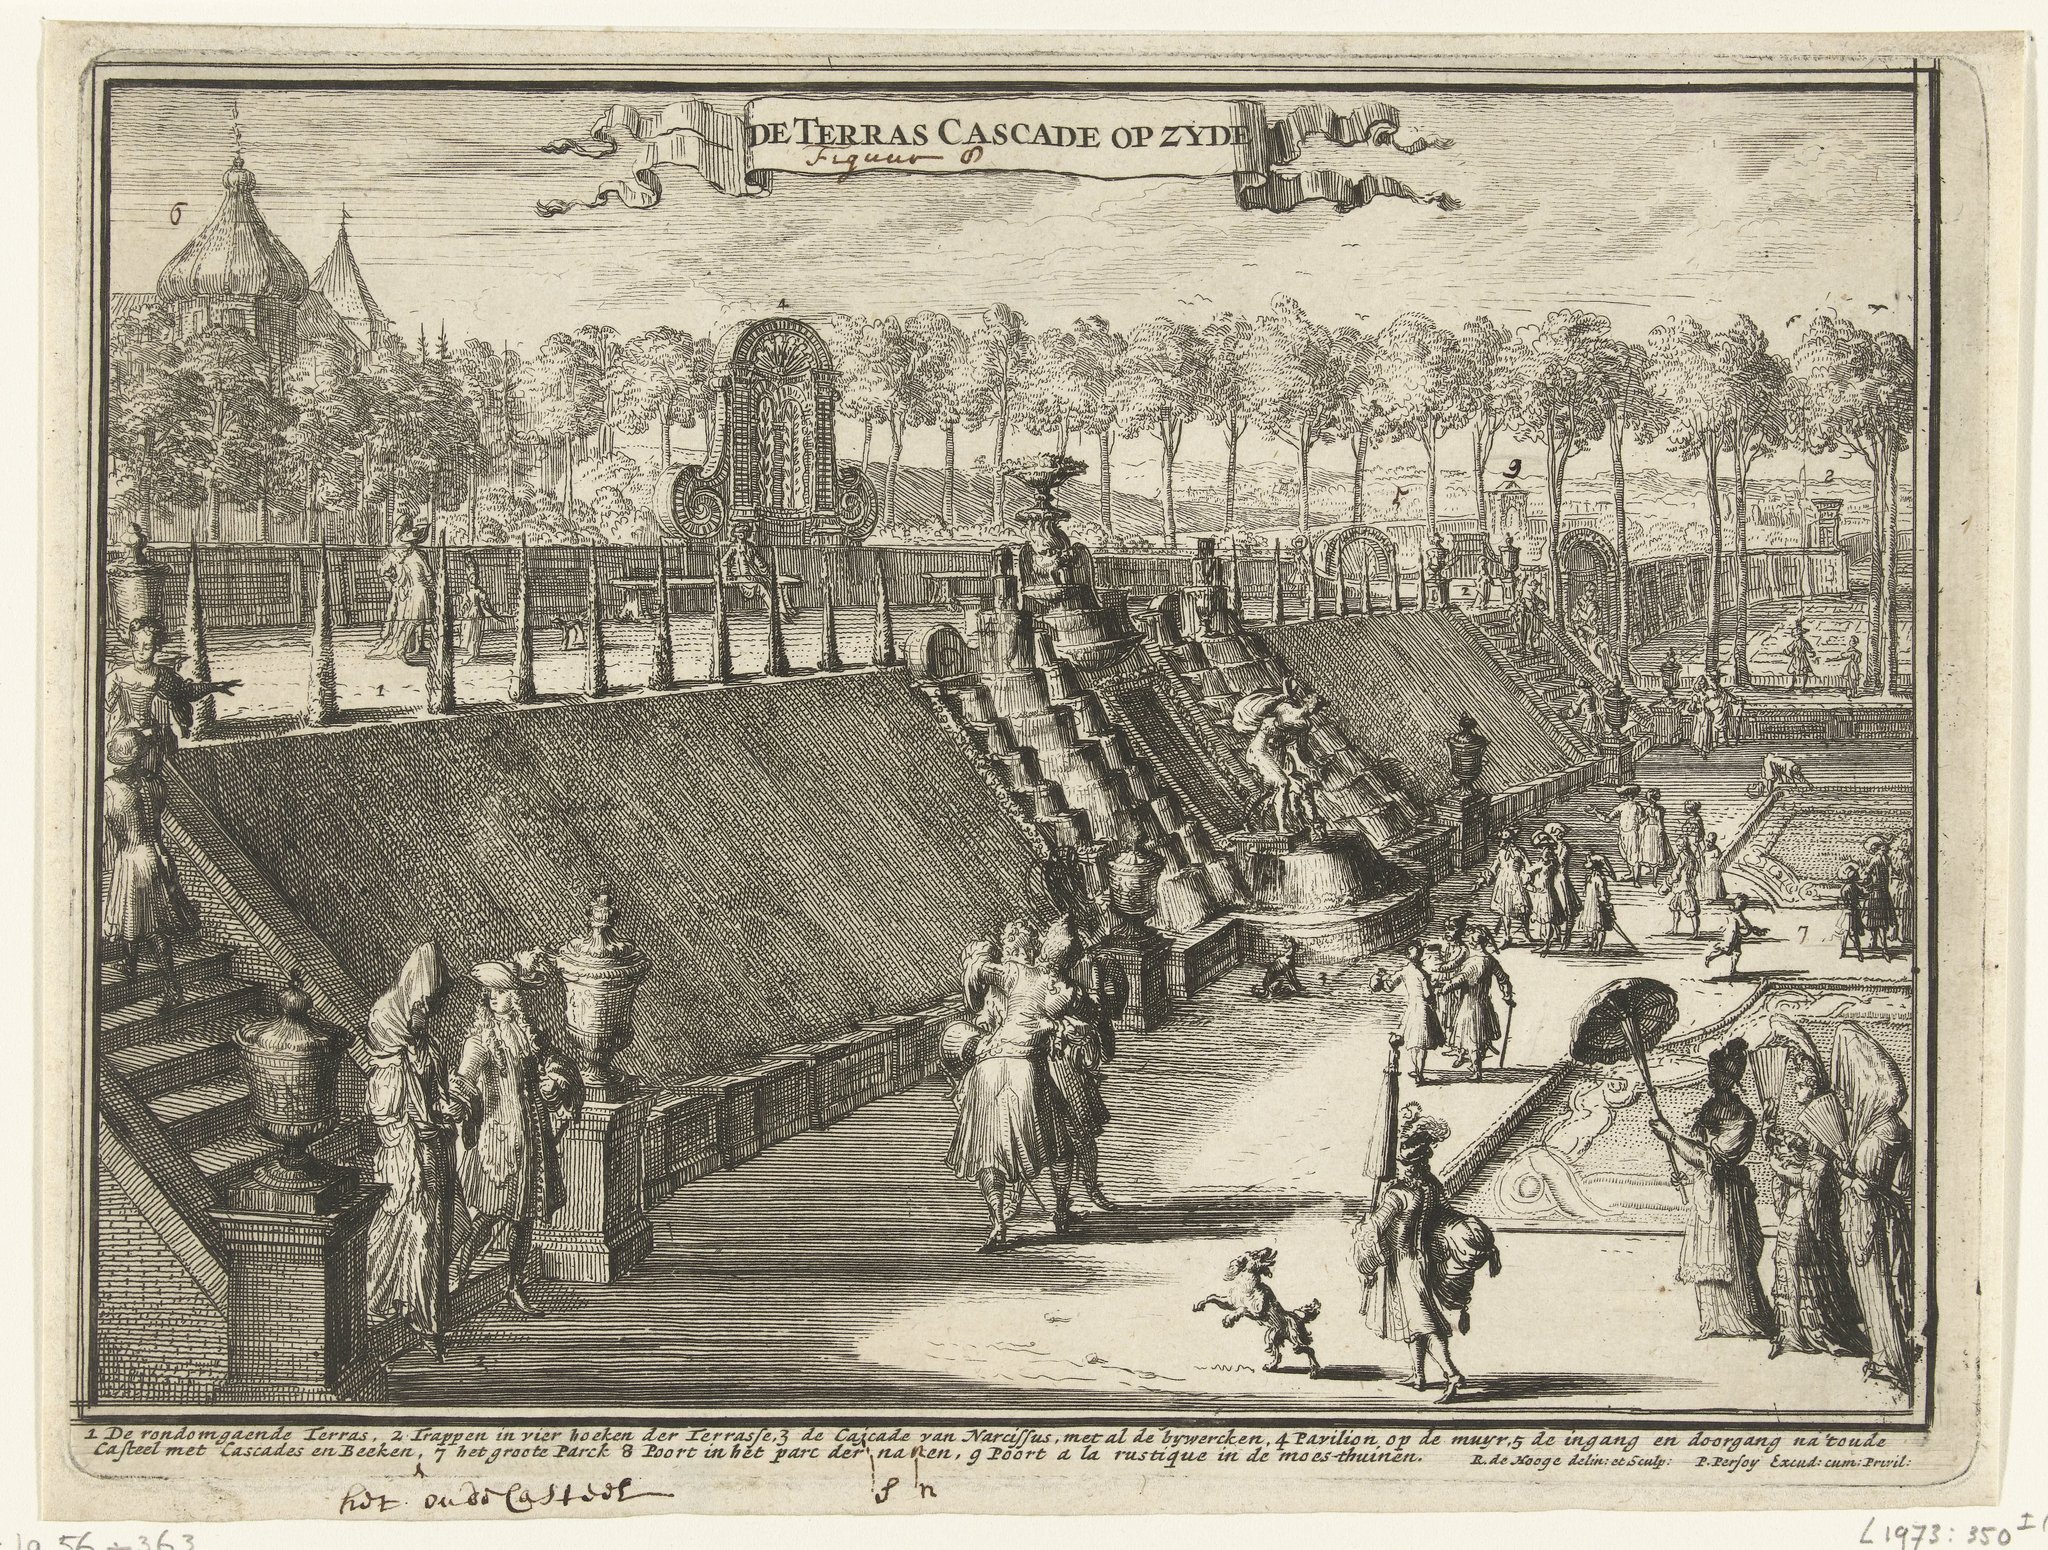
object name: print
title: Gezicht (van opzij) op een terraswaterval in het park van Paleis Het Loo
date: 1690-1694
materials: paper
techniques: etching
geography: amsterdam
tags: the hague, william iii (prince of orange and king of england, scotland, and ireland), garden, palace, garden cascade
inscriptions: inscription: ‘het oude casteel’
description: Gezicht (van opzij) op een terraswaterval in het park van Paleis Het Loo. In de buurt van de waterval voorname wandelaars. In de marge onder de voorstelling een legenda in het Nederlands. Dit blad maakt deel uit van een omvangrijke prent met een gezicht op Paleis Het Loo, omgeven door dertien gezichten op de bijbehorende gebouwen en het bijbehorende park (boven, links, rechts), en een profiel van het paleis (onder).